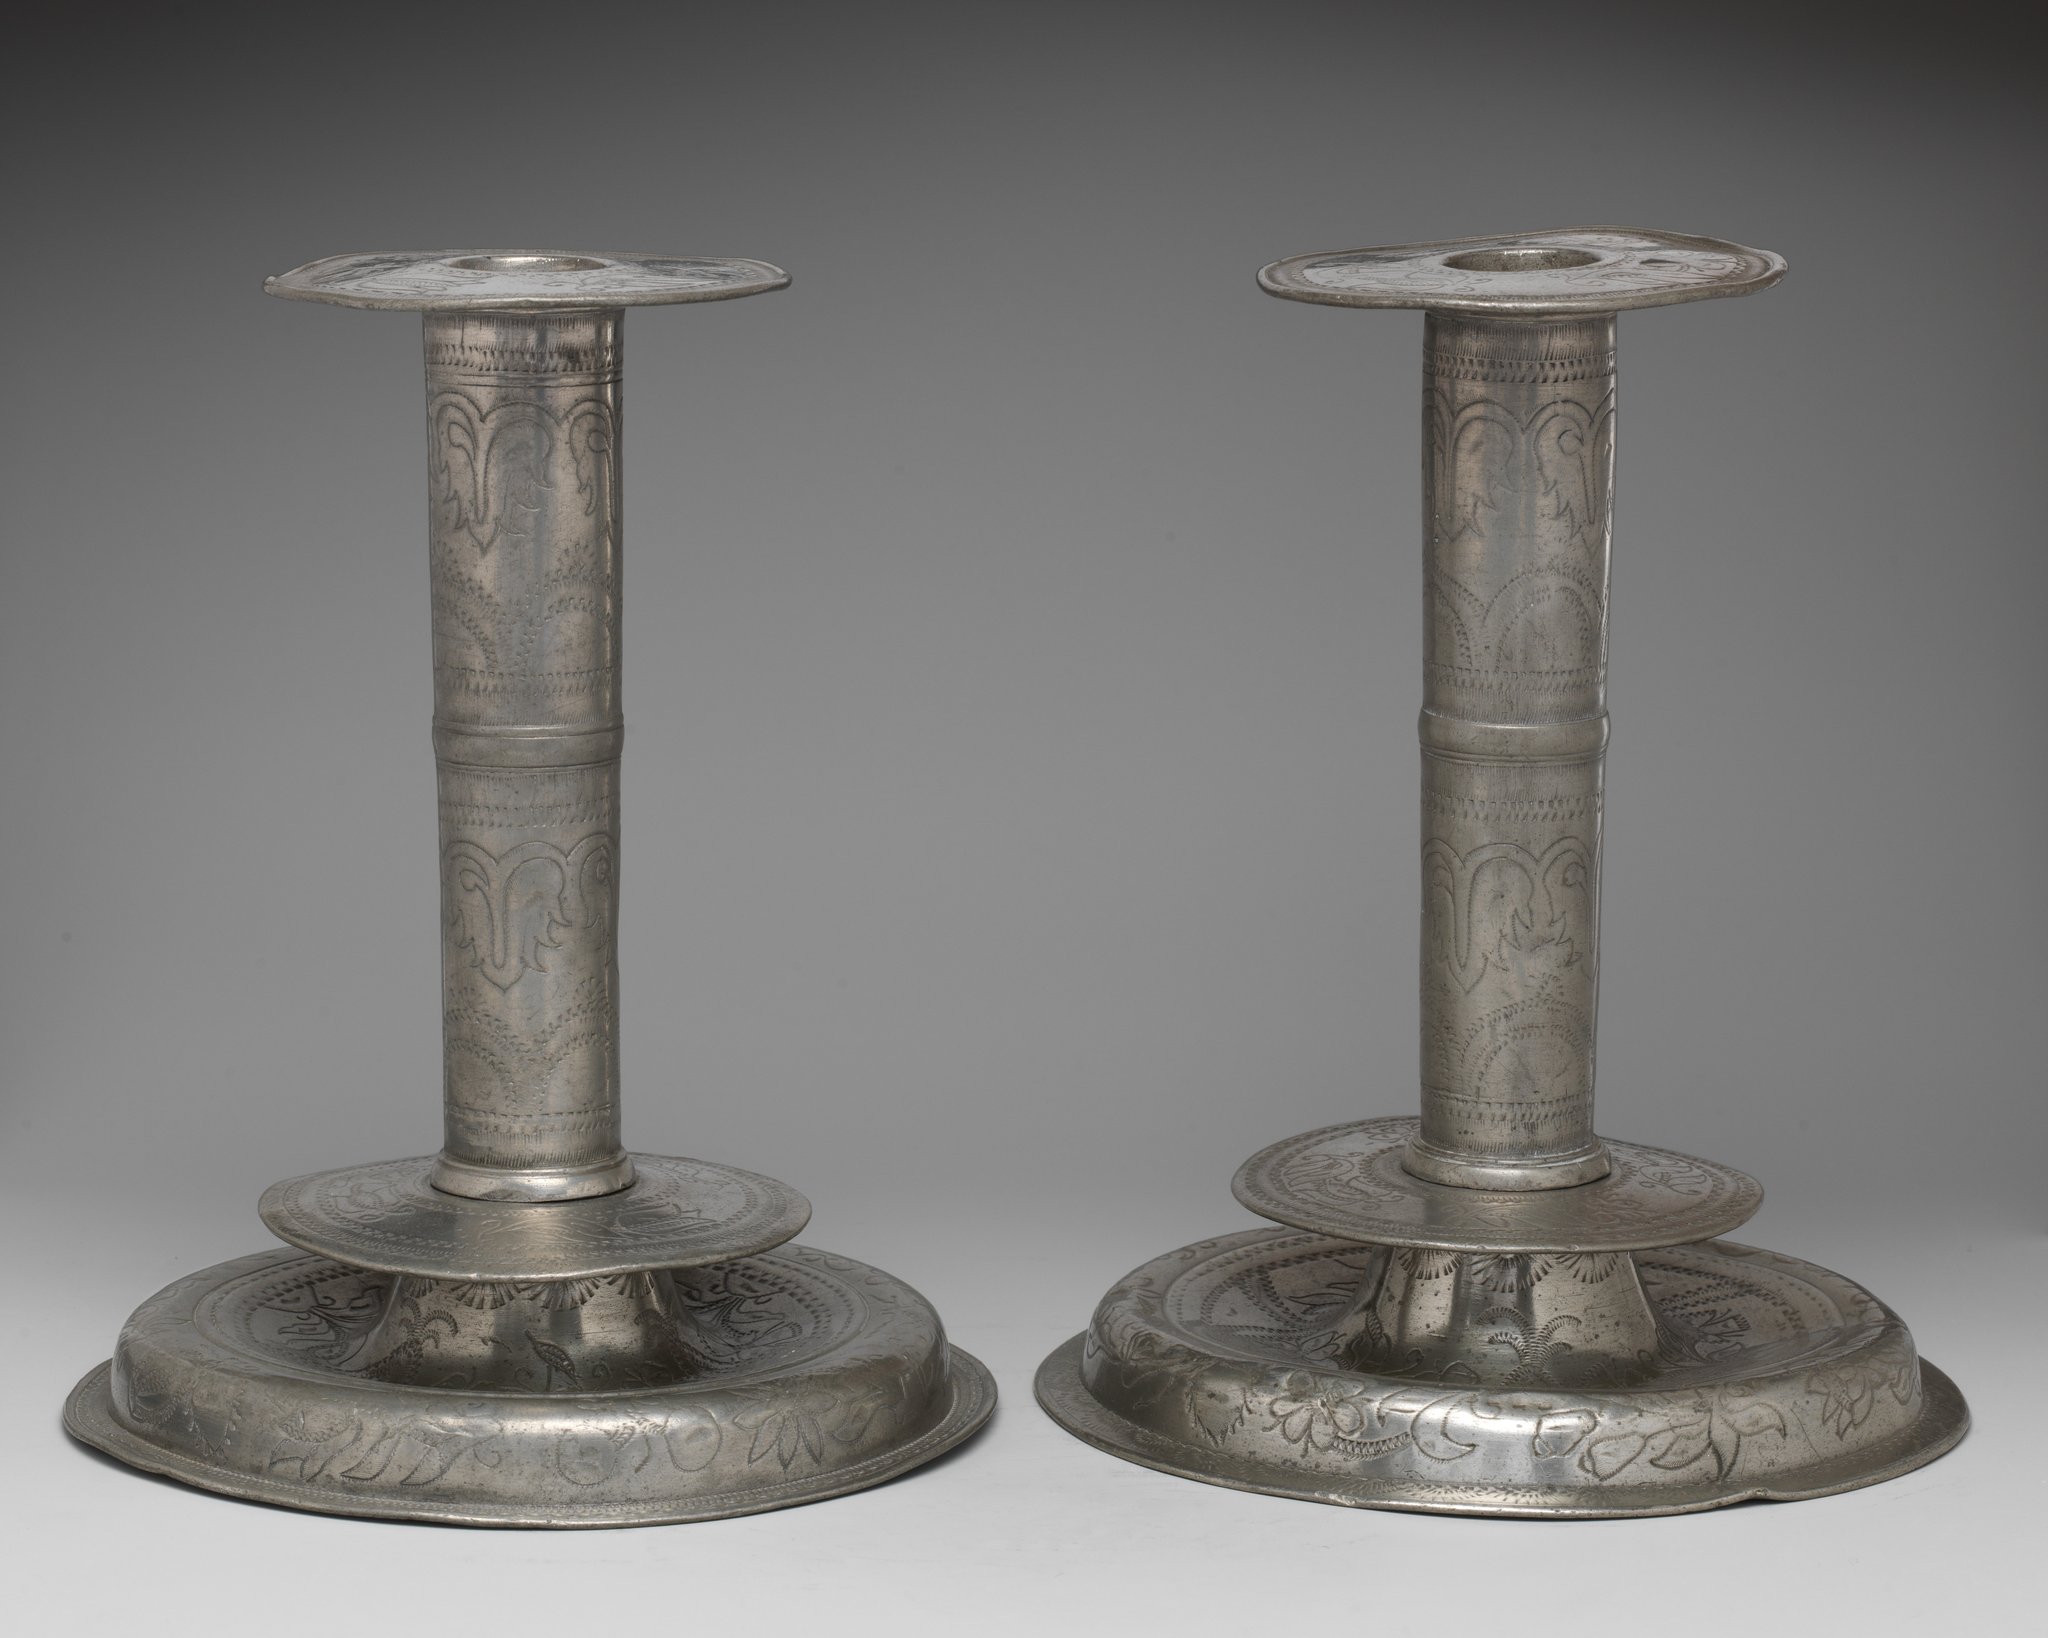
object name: candlestick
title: Pair of candlesticks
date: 1660-1690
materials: pewter